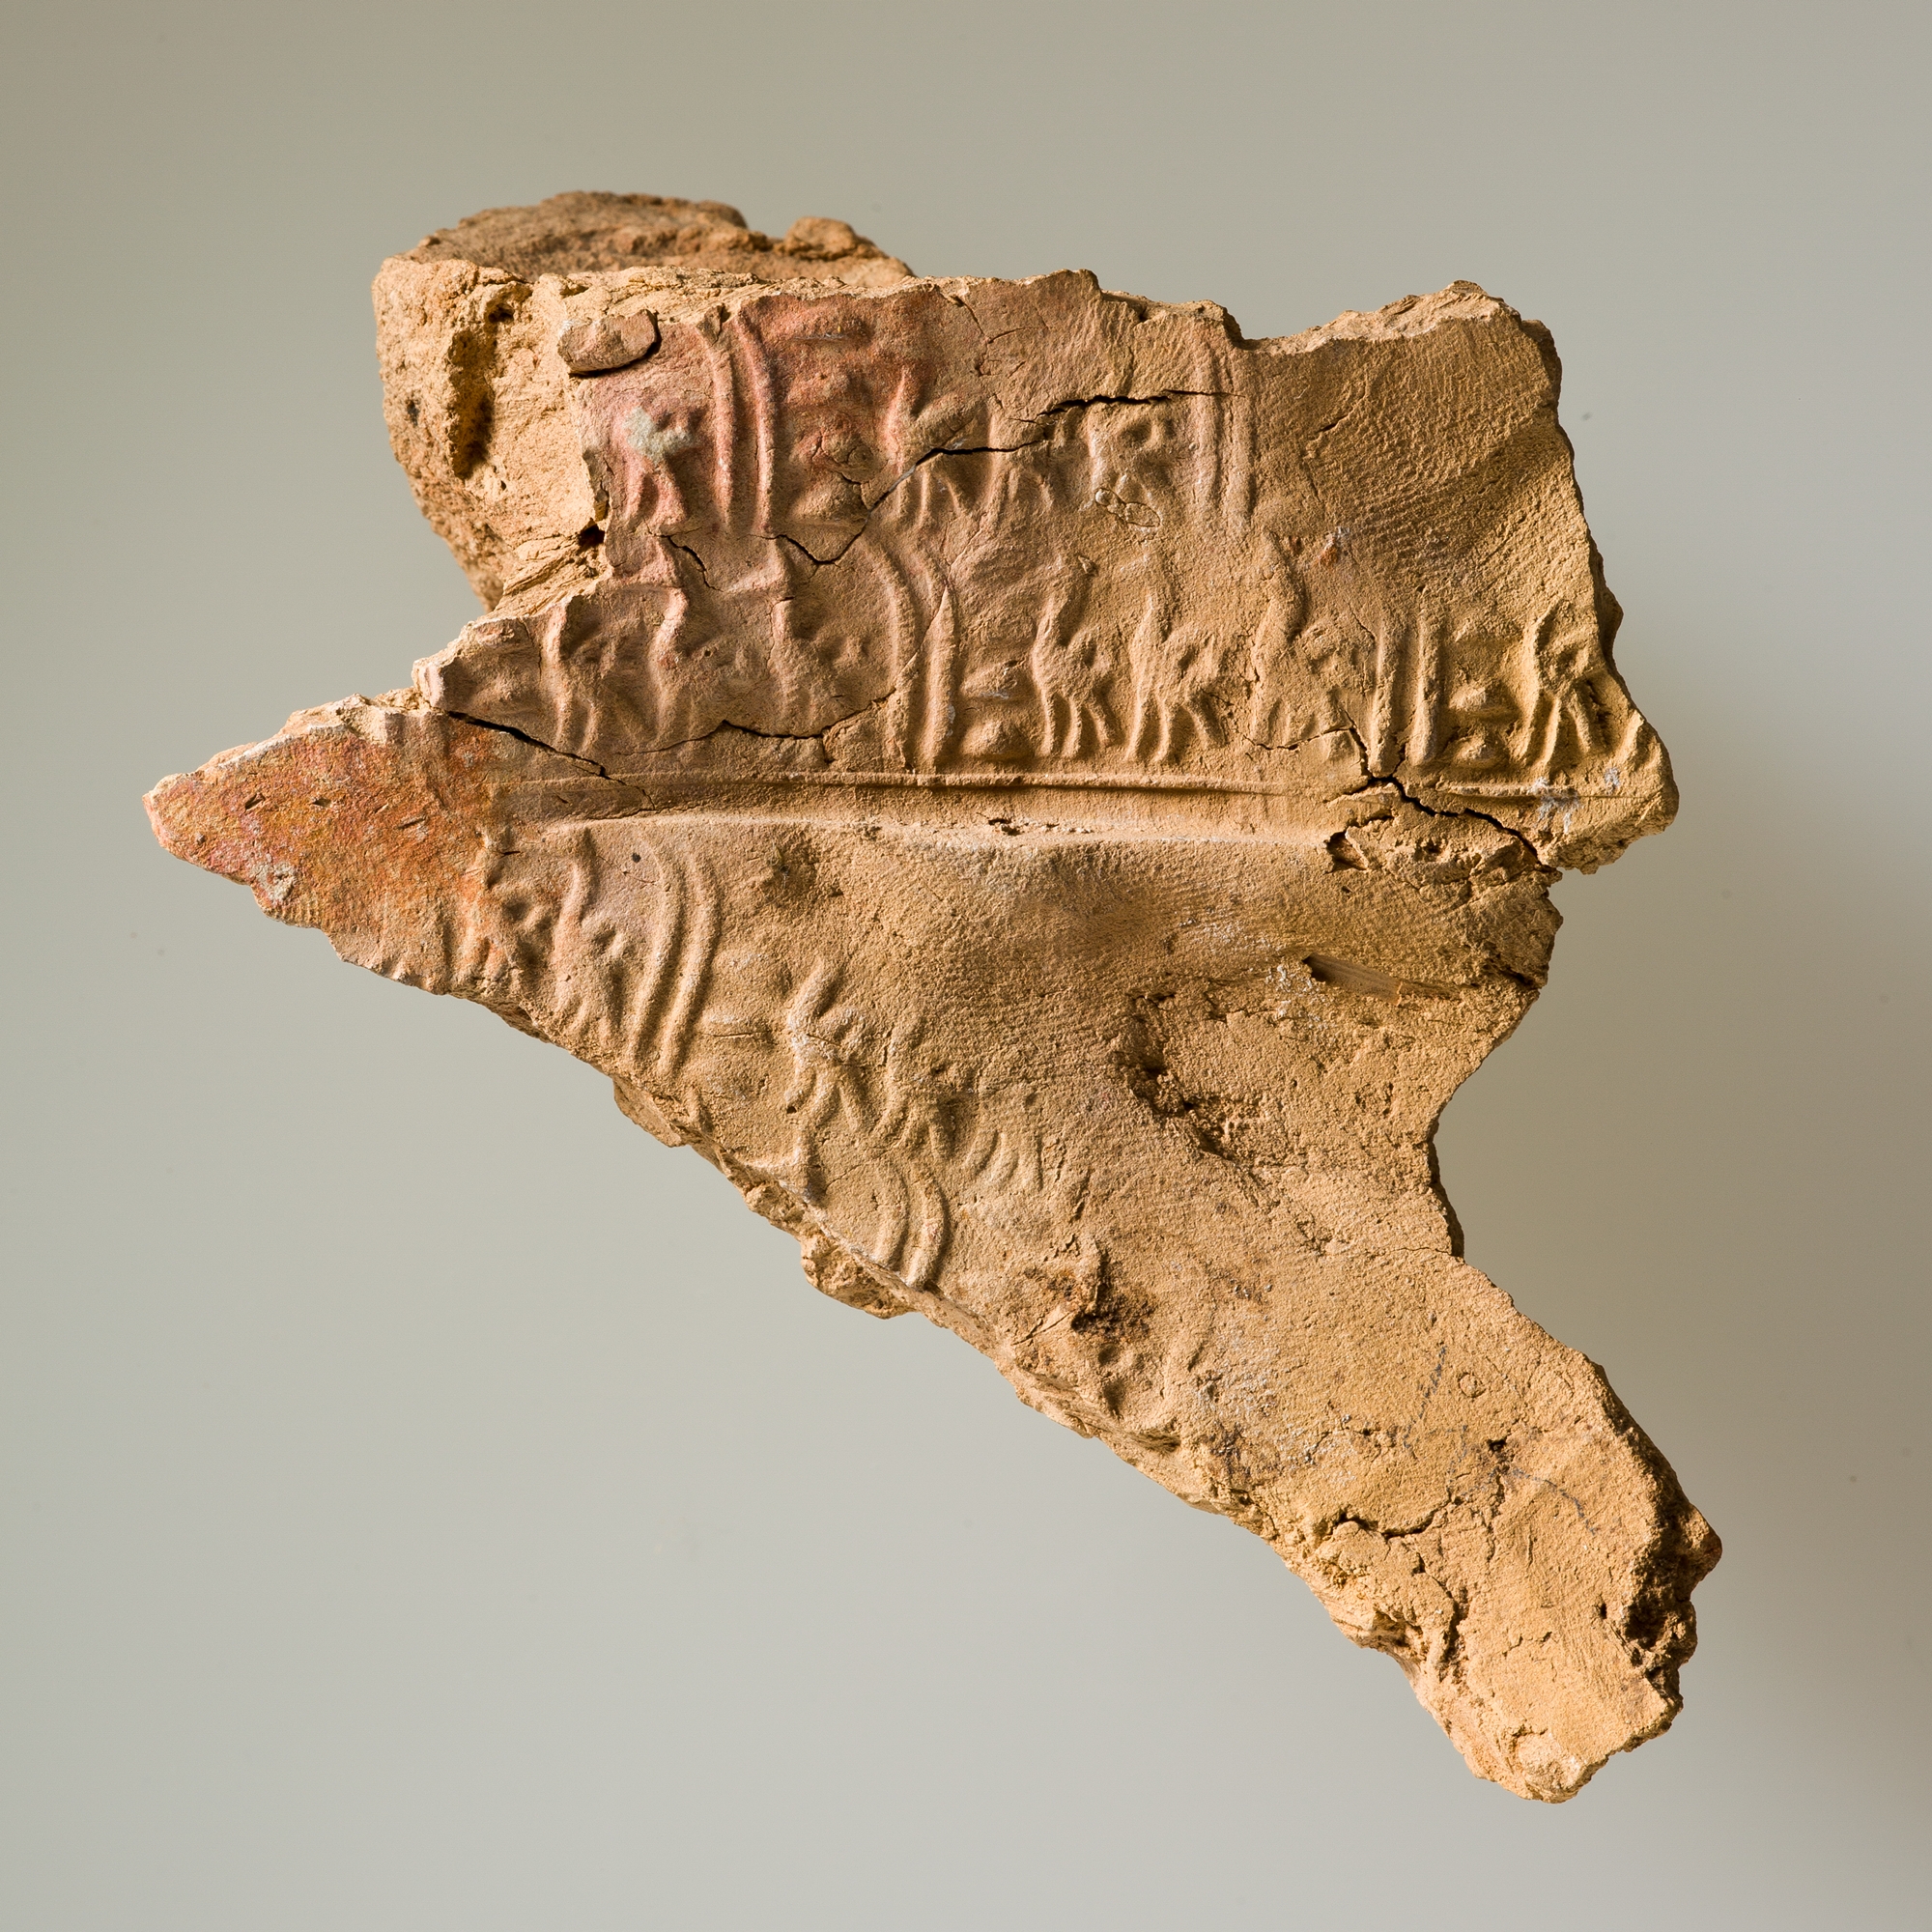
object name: sealing, jar, neithhotep,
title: Clay jar sealing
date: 3100-2649 BCE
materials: clay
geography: egypt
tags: hieroglyphs